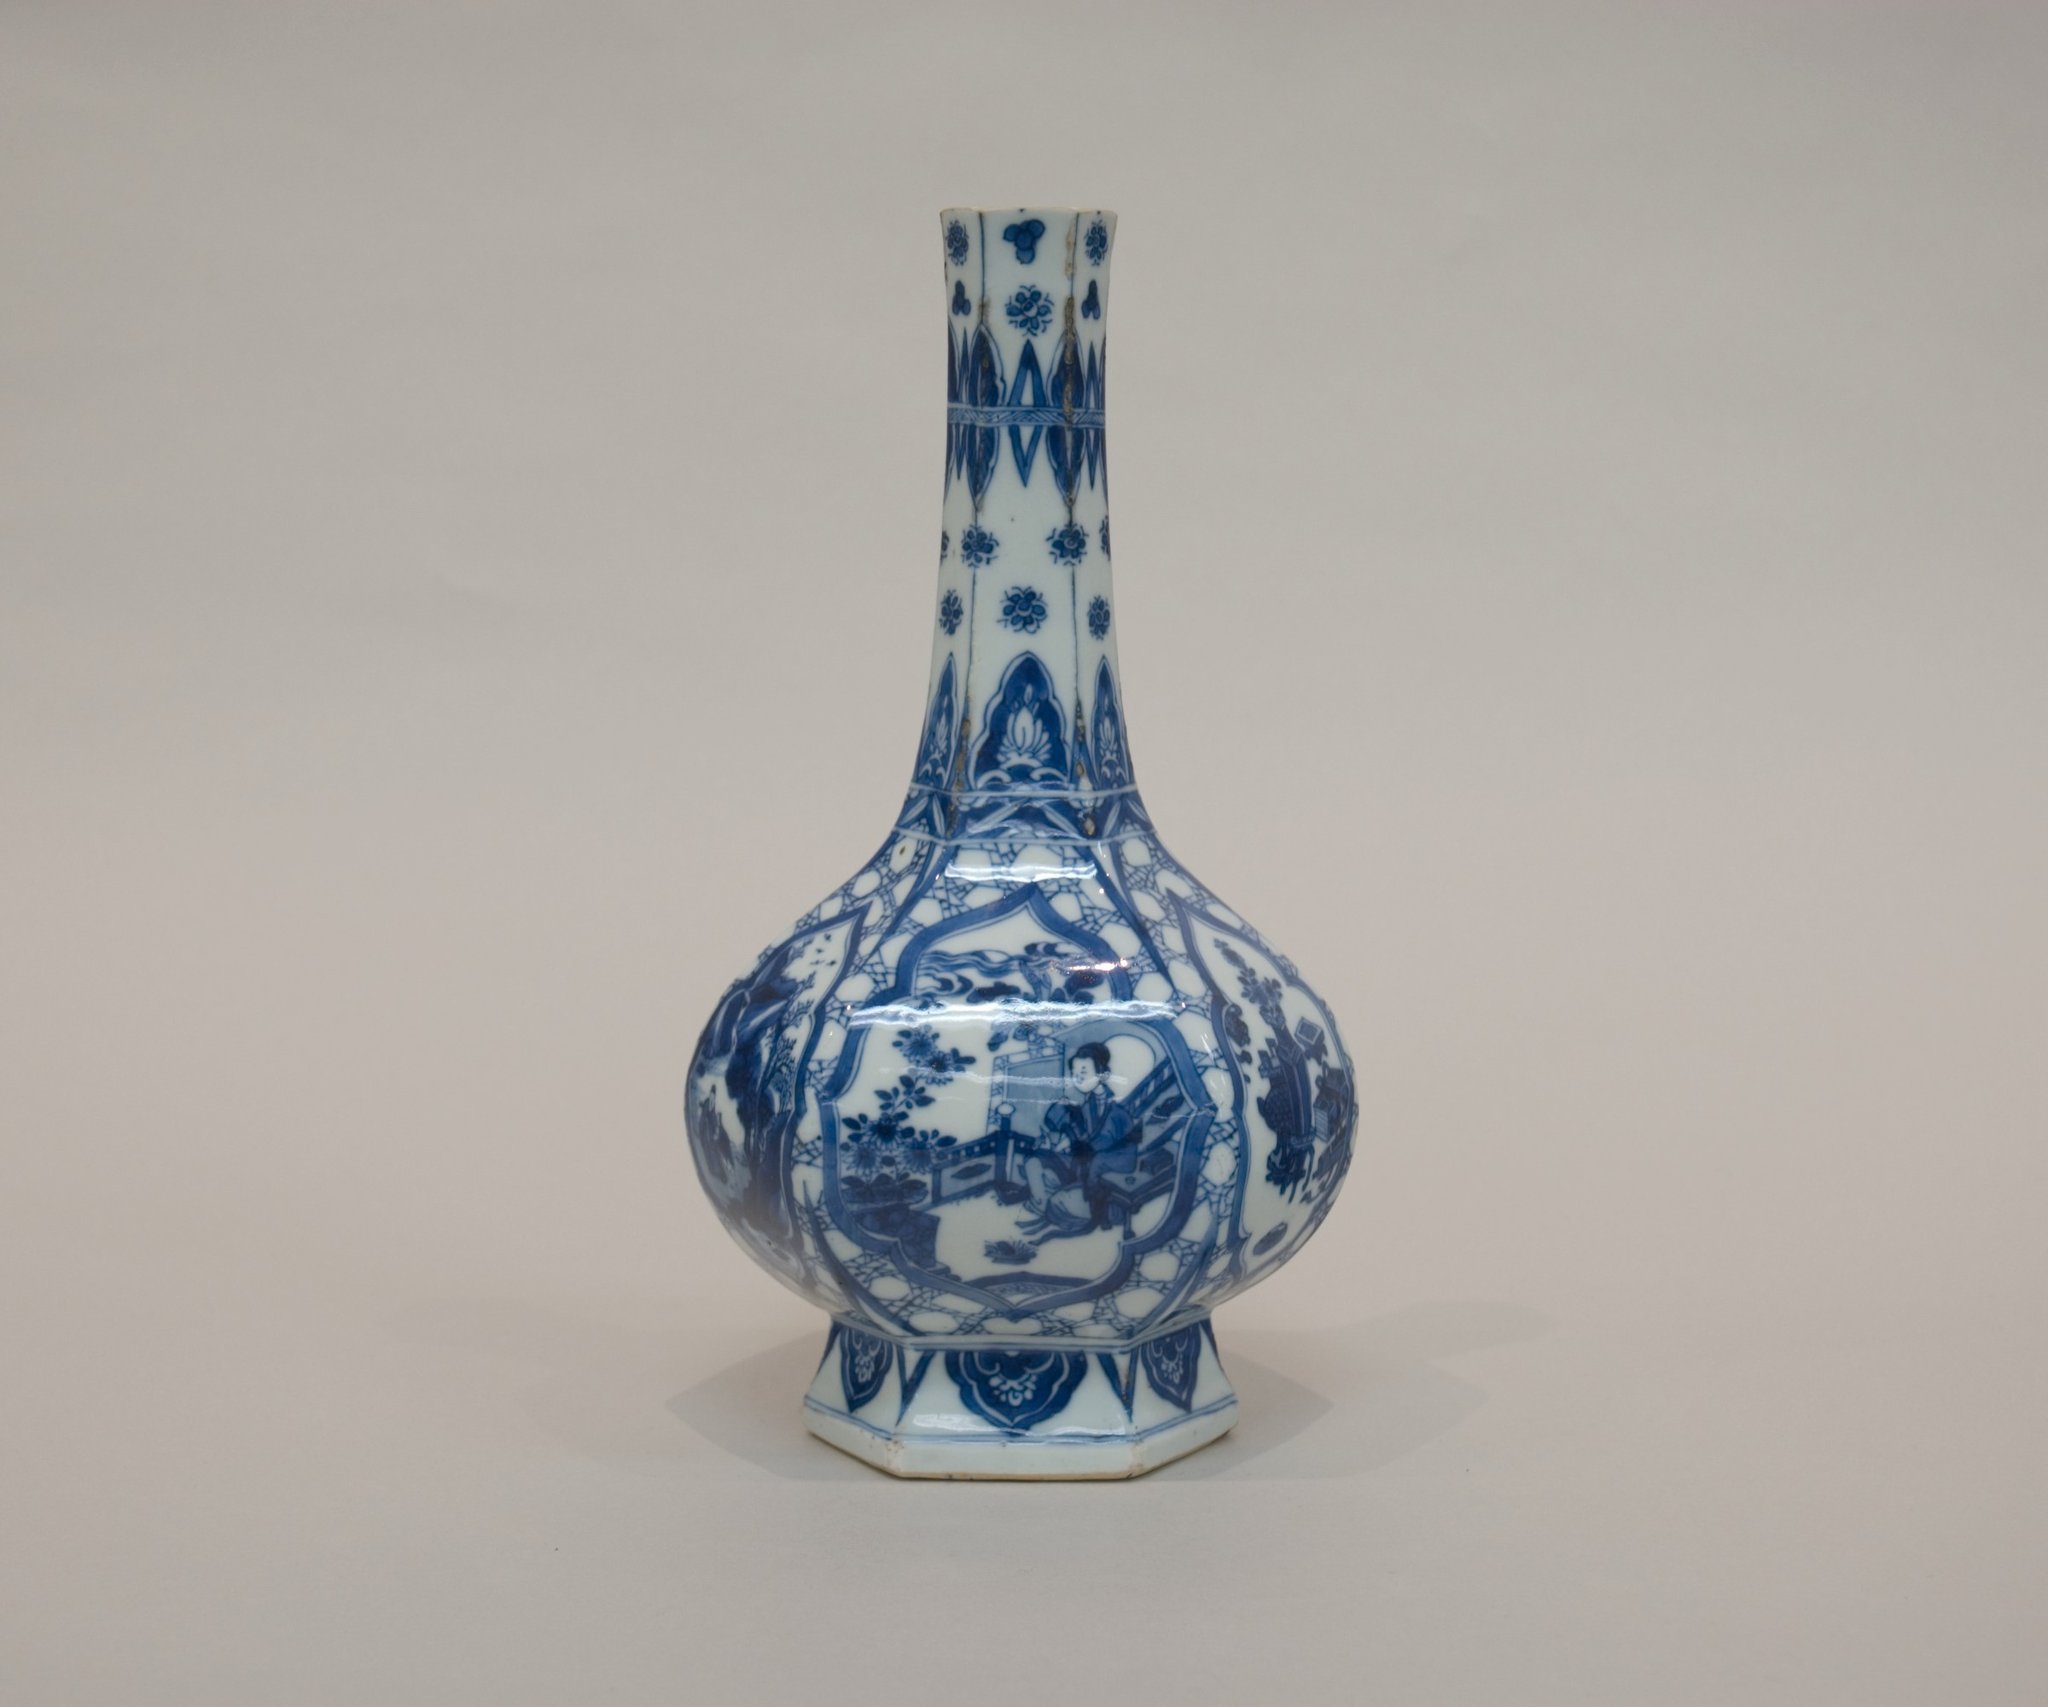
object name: vase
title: Hexagonal vase with ladies, plants, and landscape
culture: chinese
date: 1667-1733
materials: cobalt, porcelain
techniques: painting, underglaze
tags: women